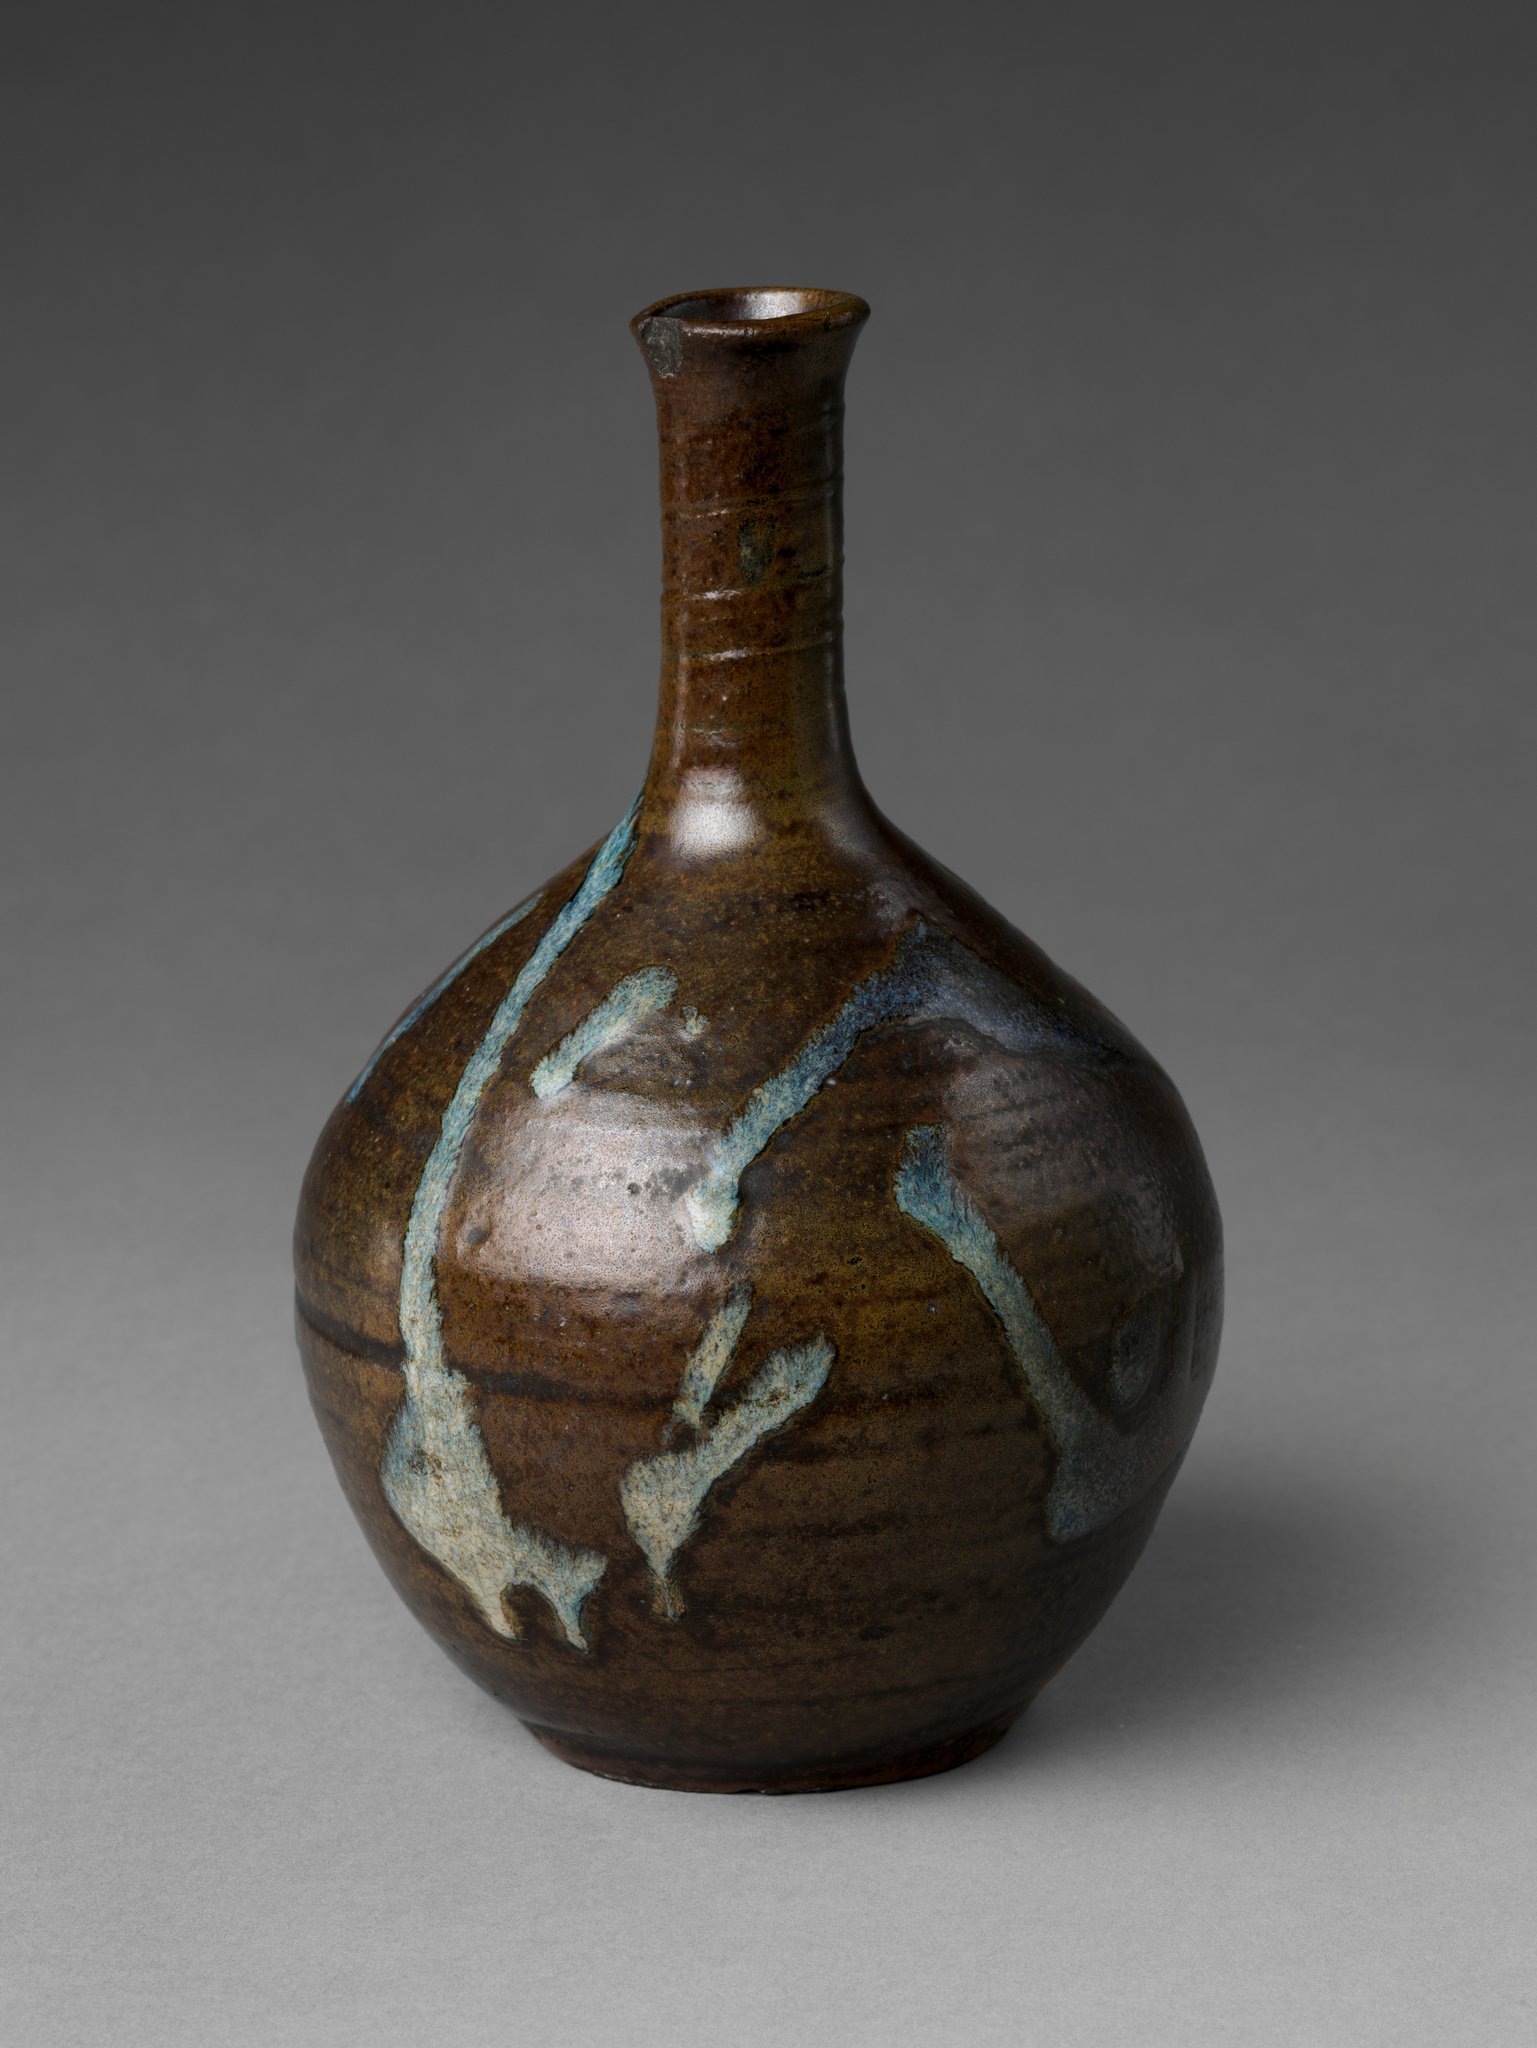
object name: bottle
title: Bottle with Splashed Design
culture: japanese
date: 1801-1850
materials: glaze, stoneware